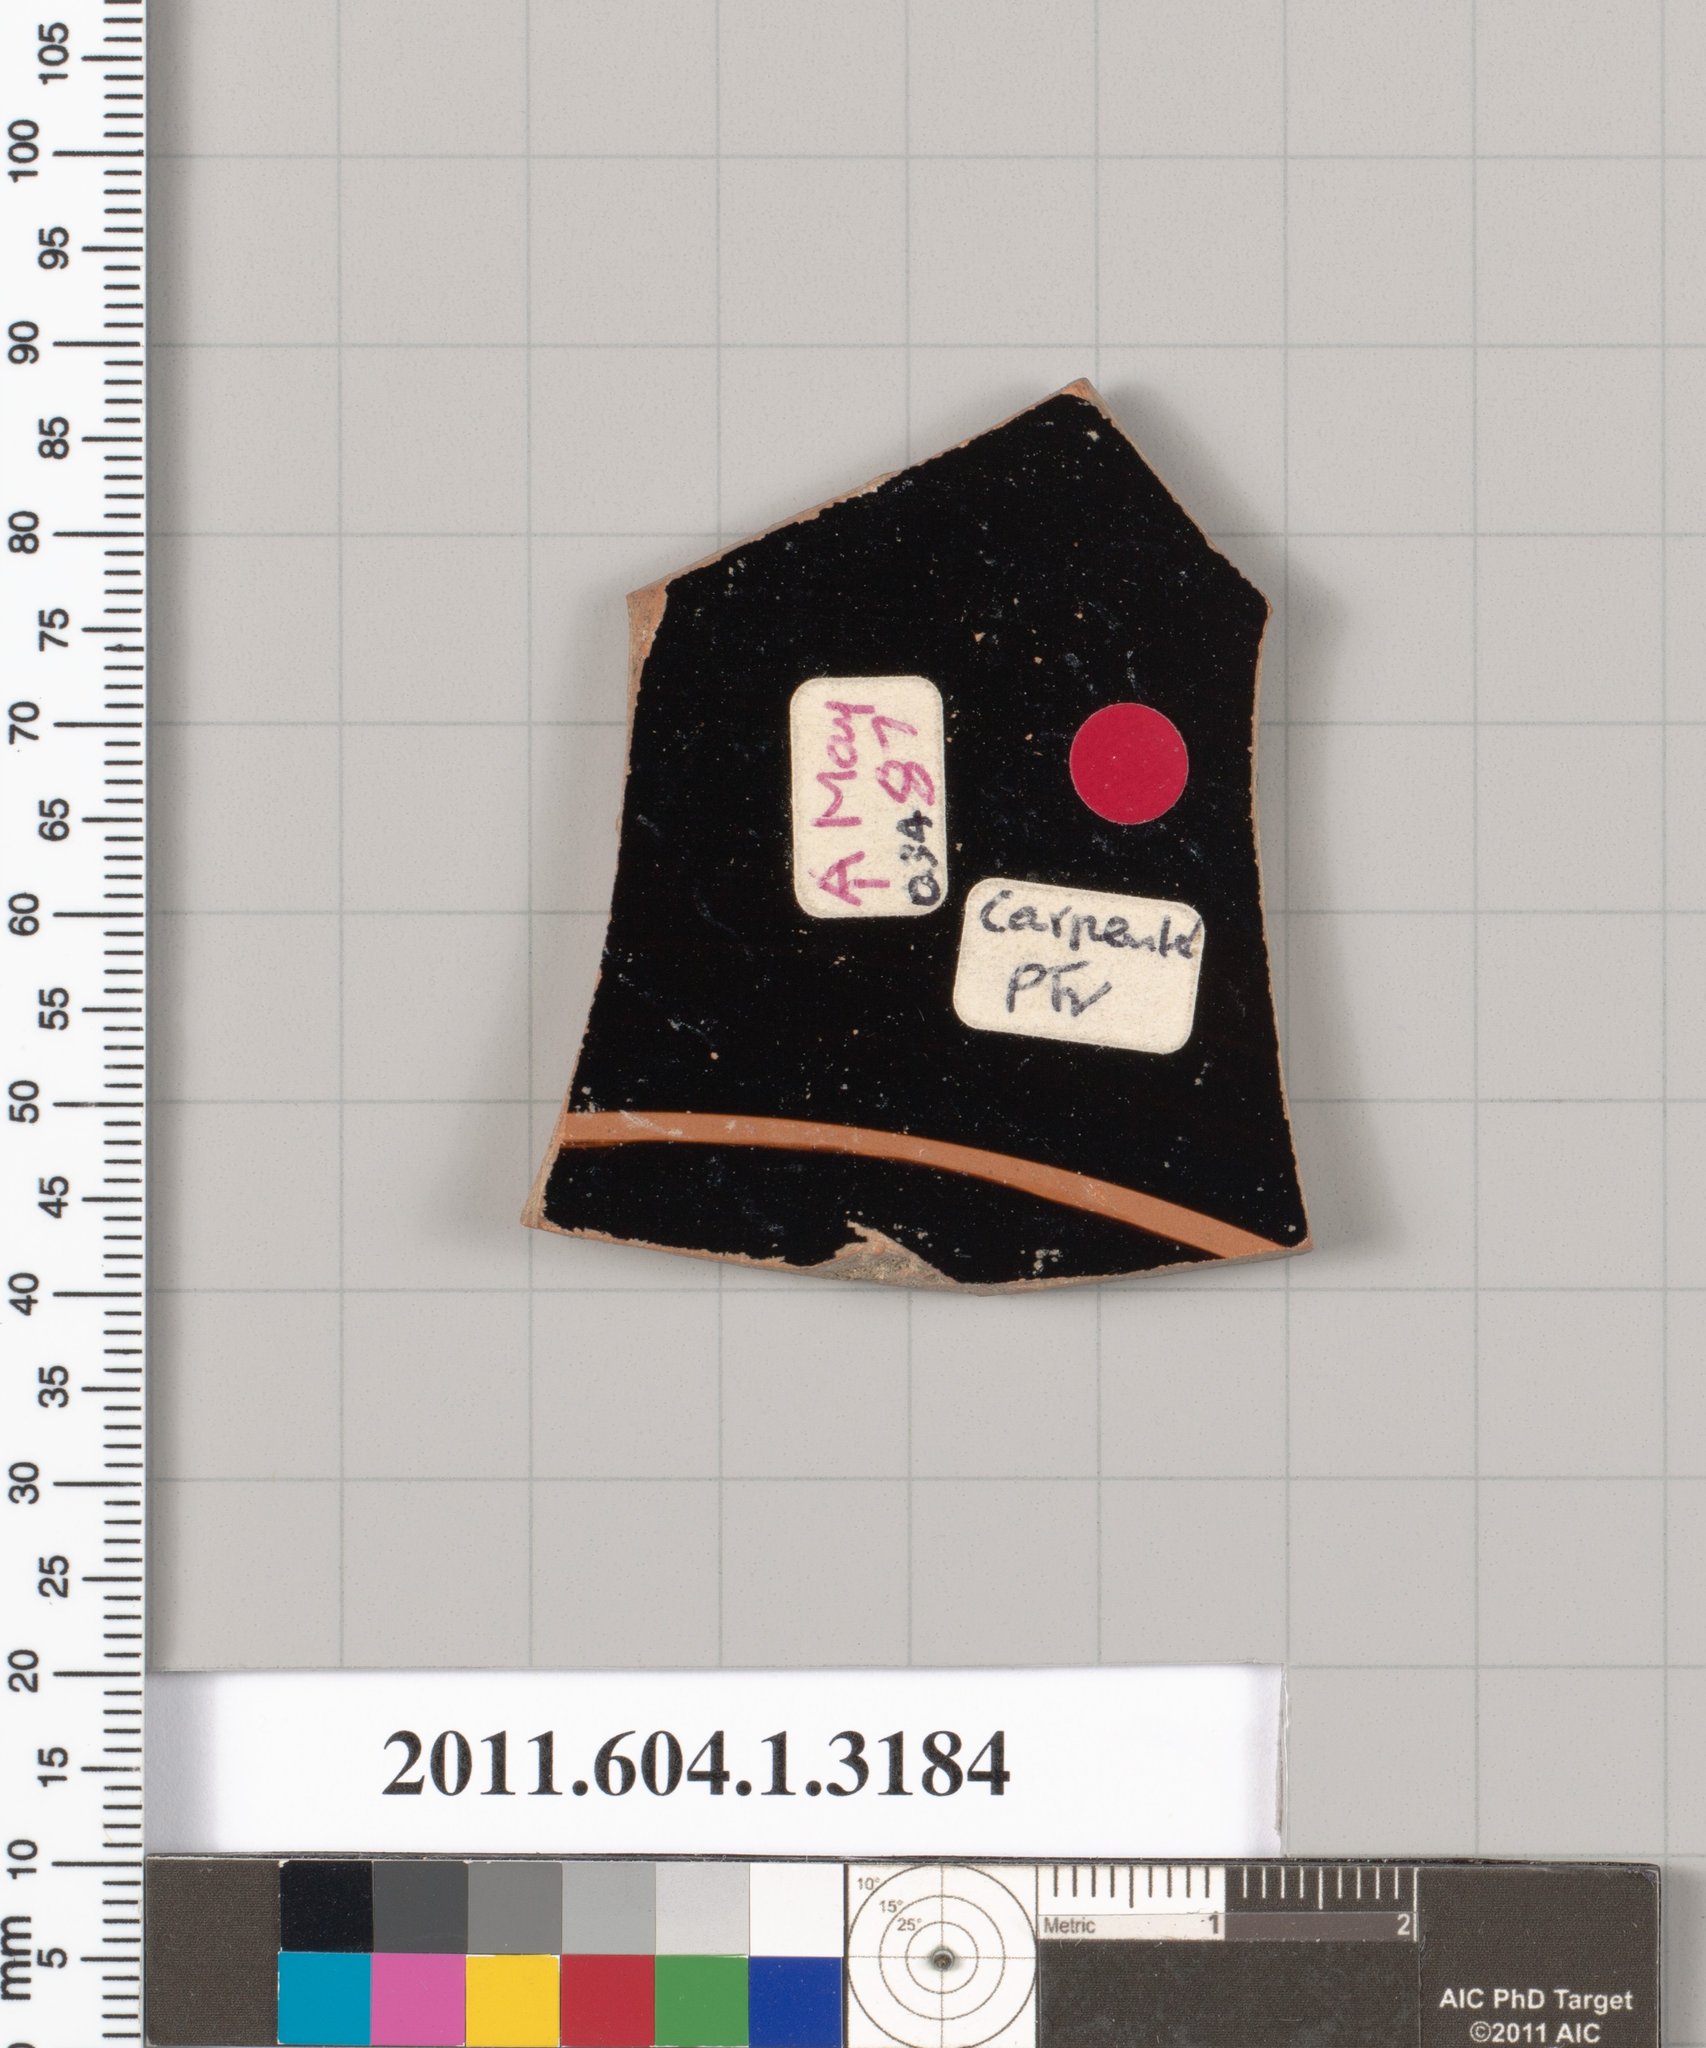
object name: kylix fragment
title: Terracotta fragment of a kylix (drinking cup)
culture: greek, attic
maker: carpenter painter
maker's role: artist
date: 515-500 BCE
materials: terracotta